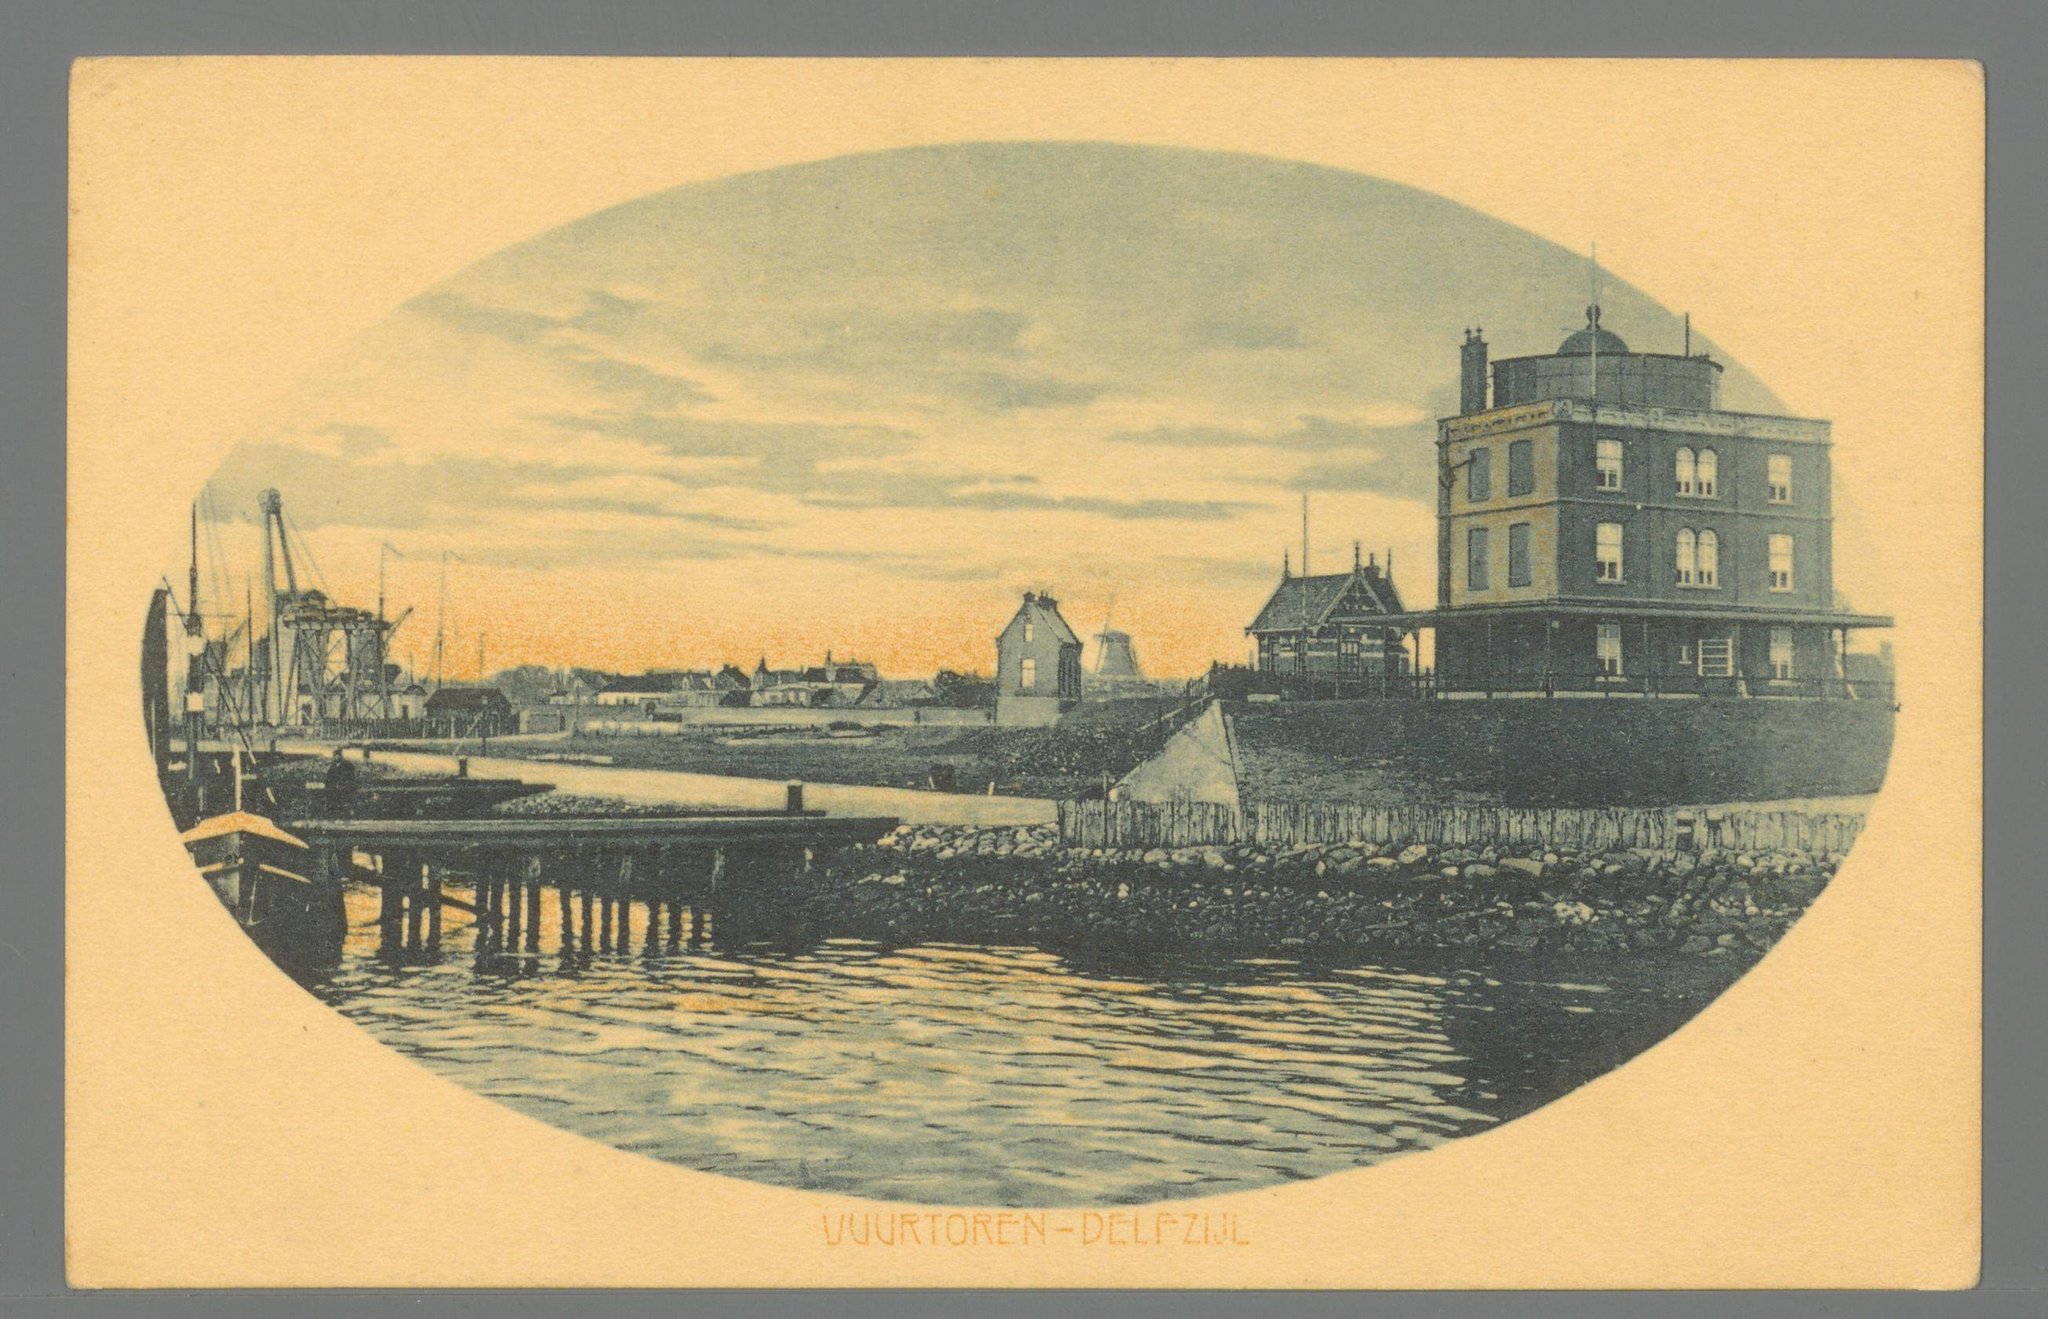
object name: photomechanical print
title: Vuurtoren - Delfzijl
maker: Anonymous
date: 1905-1915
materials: cardboard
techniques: photograph, lithograph, writing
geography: delfzijl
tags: lighthouse, lightship, city-view, and landscape with man-made constructions